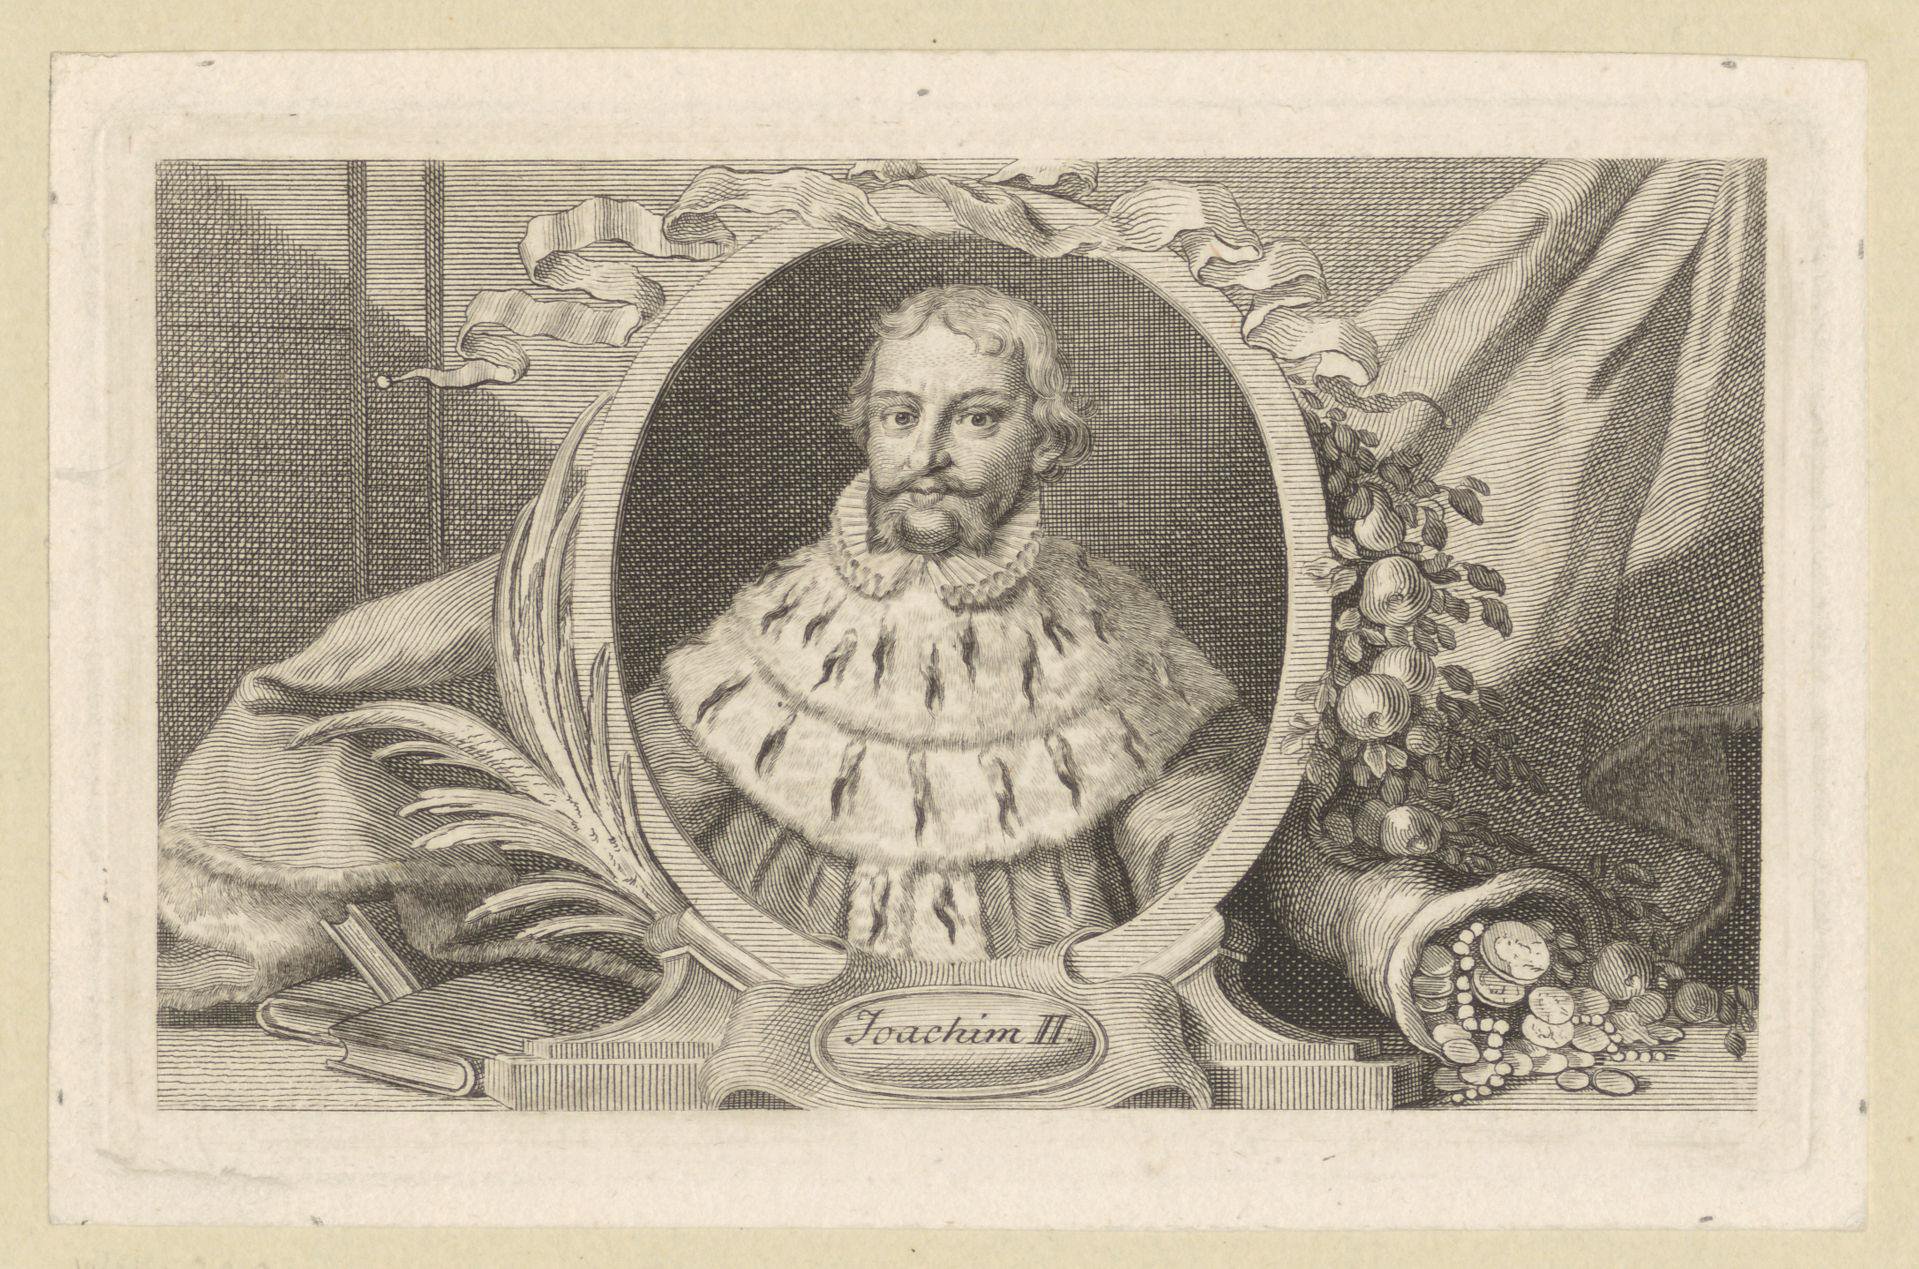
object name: print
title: Portret van Joachim II Hector, keurvorst van Brandenburg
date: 1751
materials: paper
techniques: engraving, etching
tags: historical persons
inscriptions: collector's mark: Lugt 240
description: Prent ook gebruikt in: Frederik de Grote. Mémoires pour servir a l'histoire de la maison de Brandebourg. Sanssouci, Frederik de Grote, 1751.